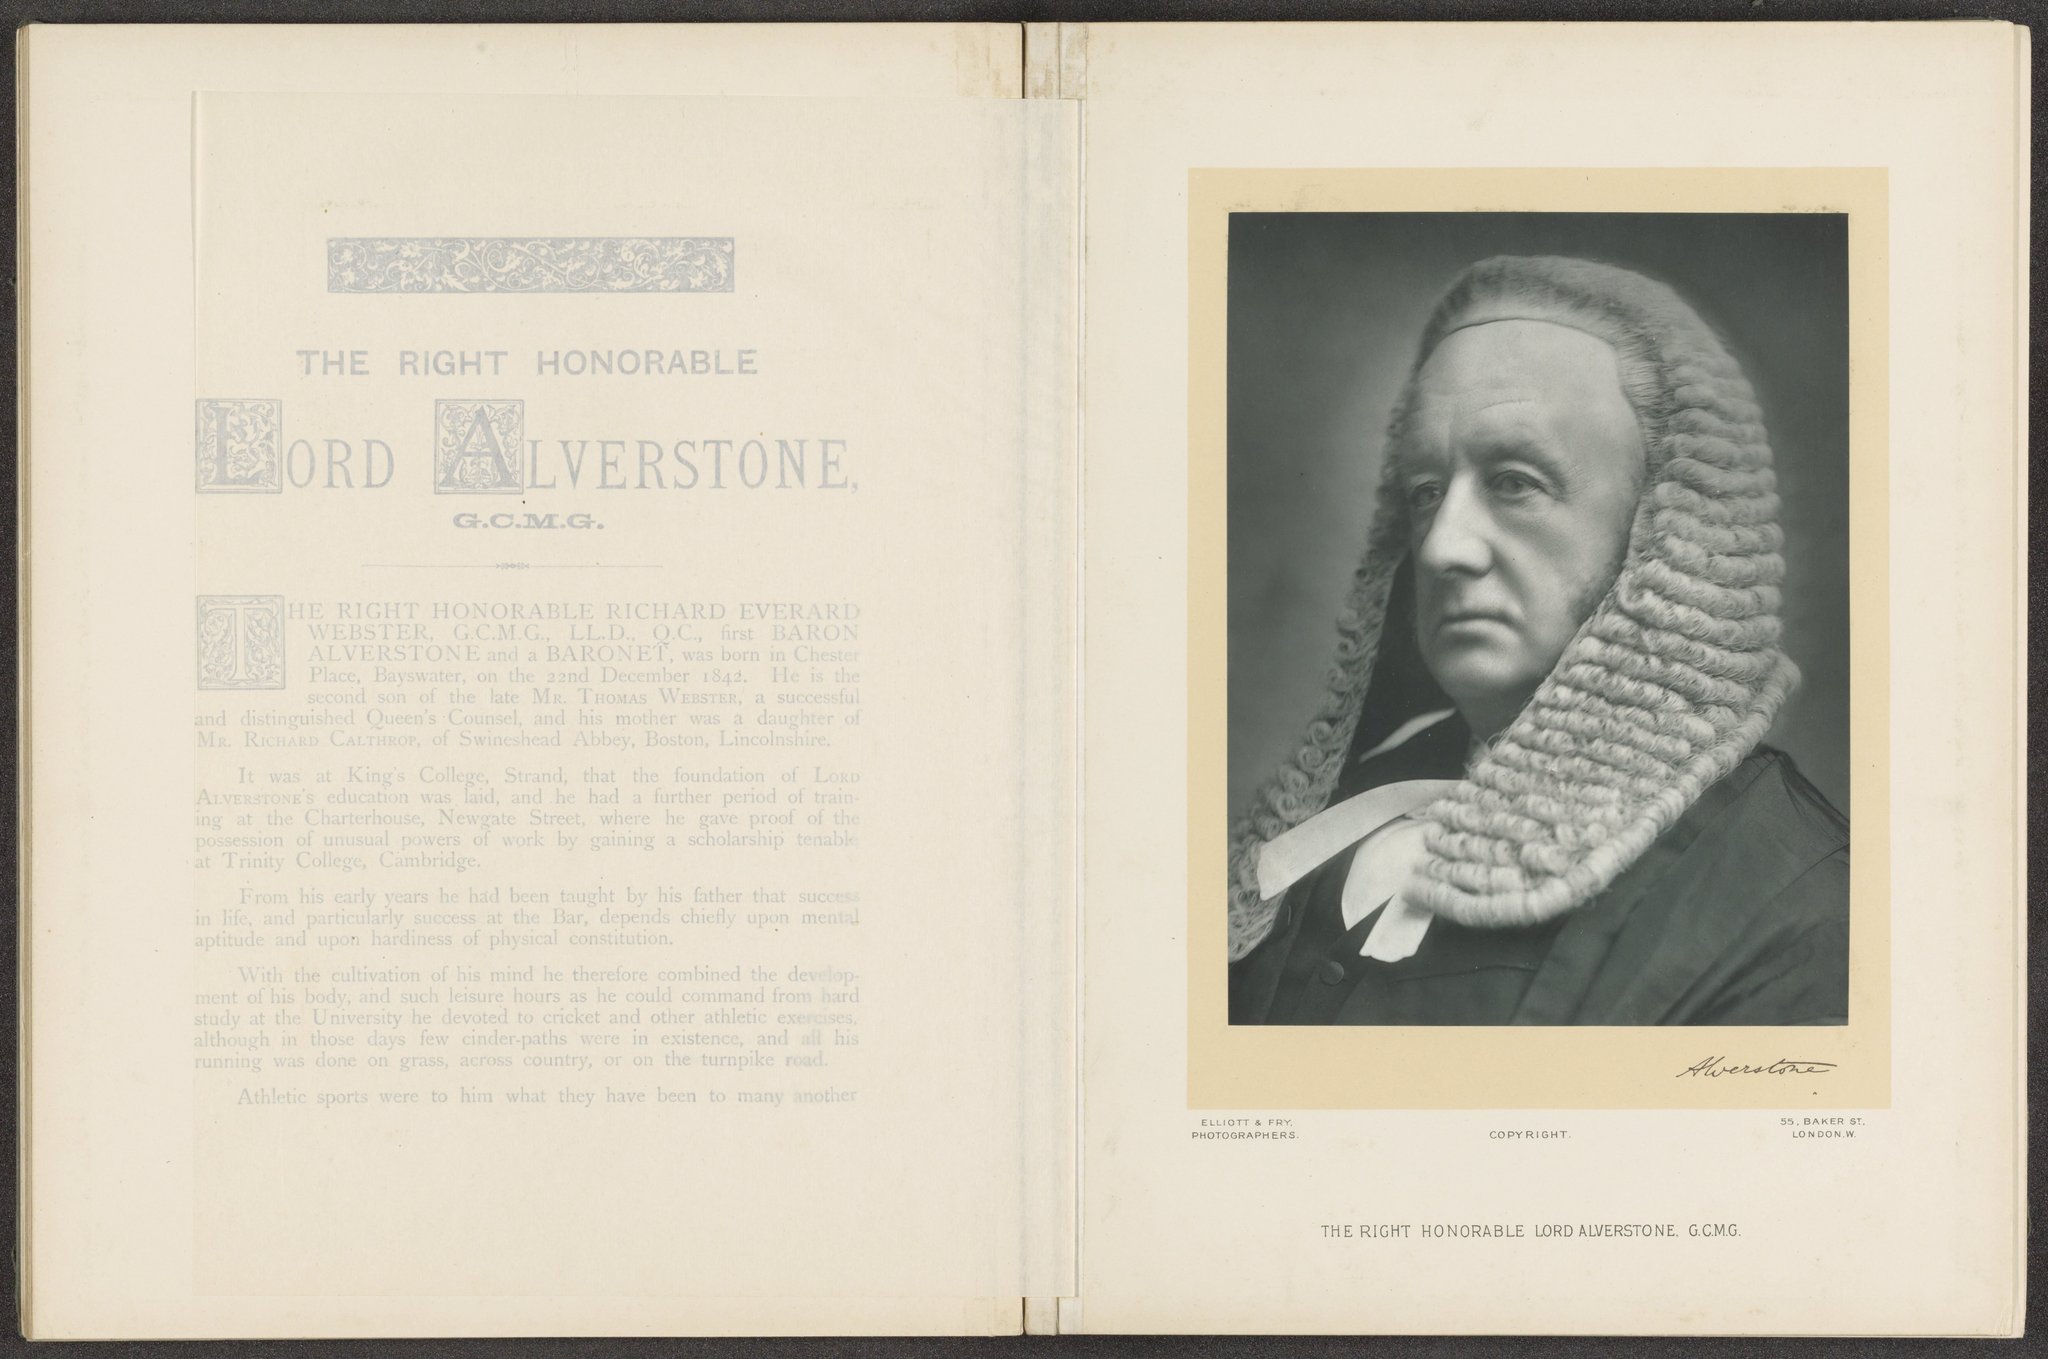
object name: photograph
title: The right honorable lord Alverstone, G.C.M.G.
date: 1893-1903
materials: paper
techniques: carbon print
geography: london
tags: historical persons (portraits and scenes from the life) (+ (full) bust portrait), wig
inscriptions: annotation, inscription: ‘55, Baker St, London, W.’